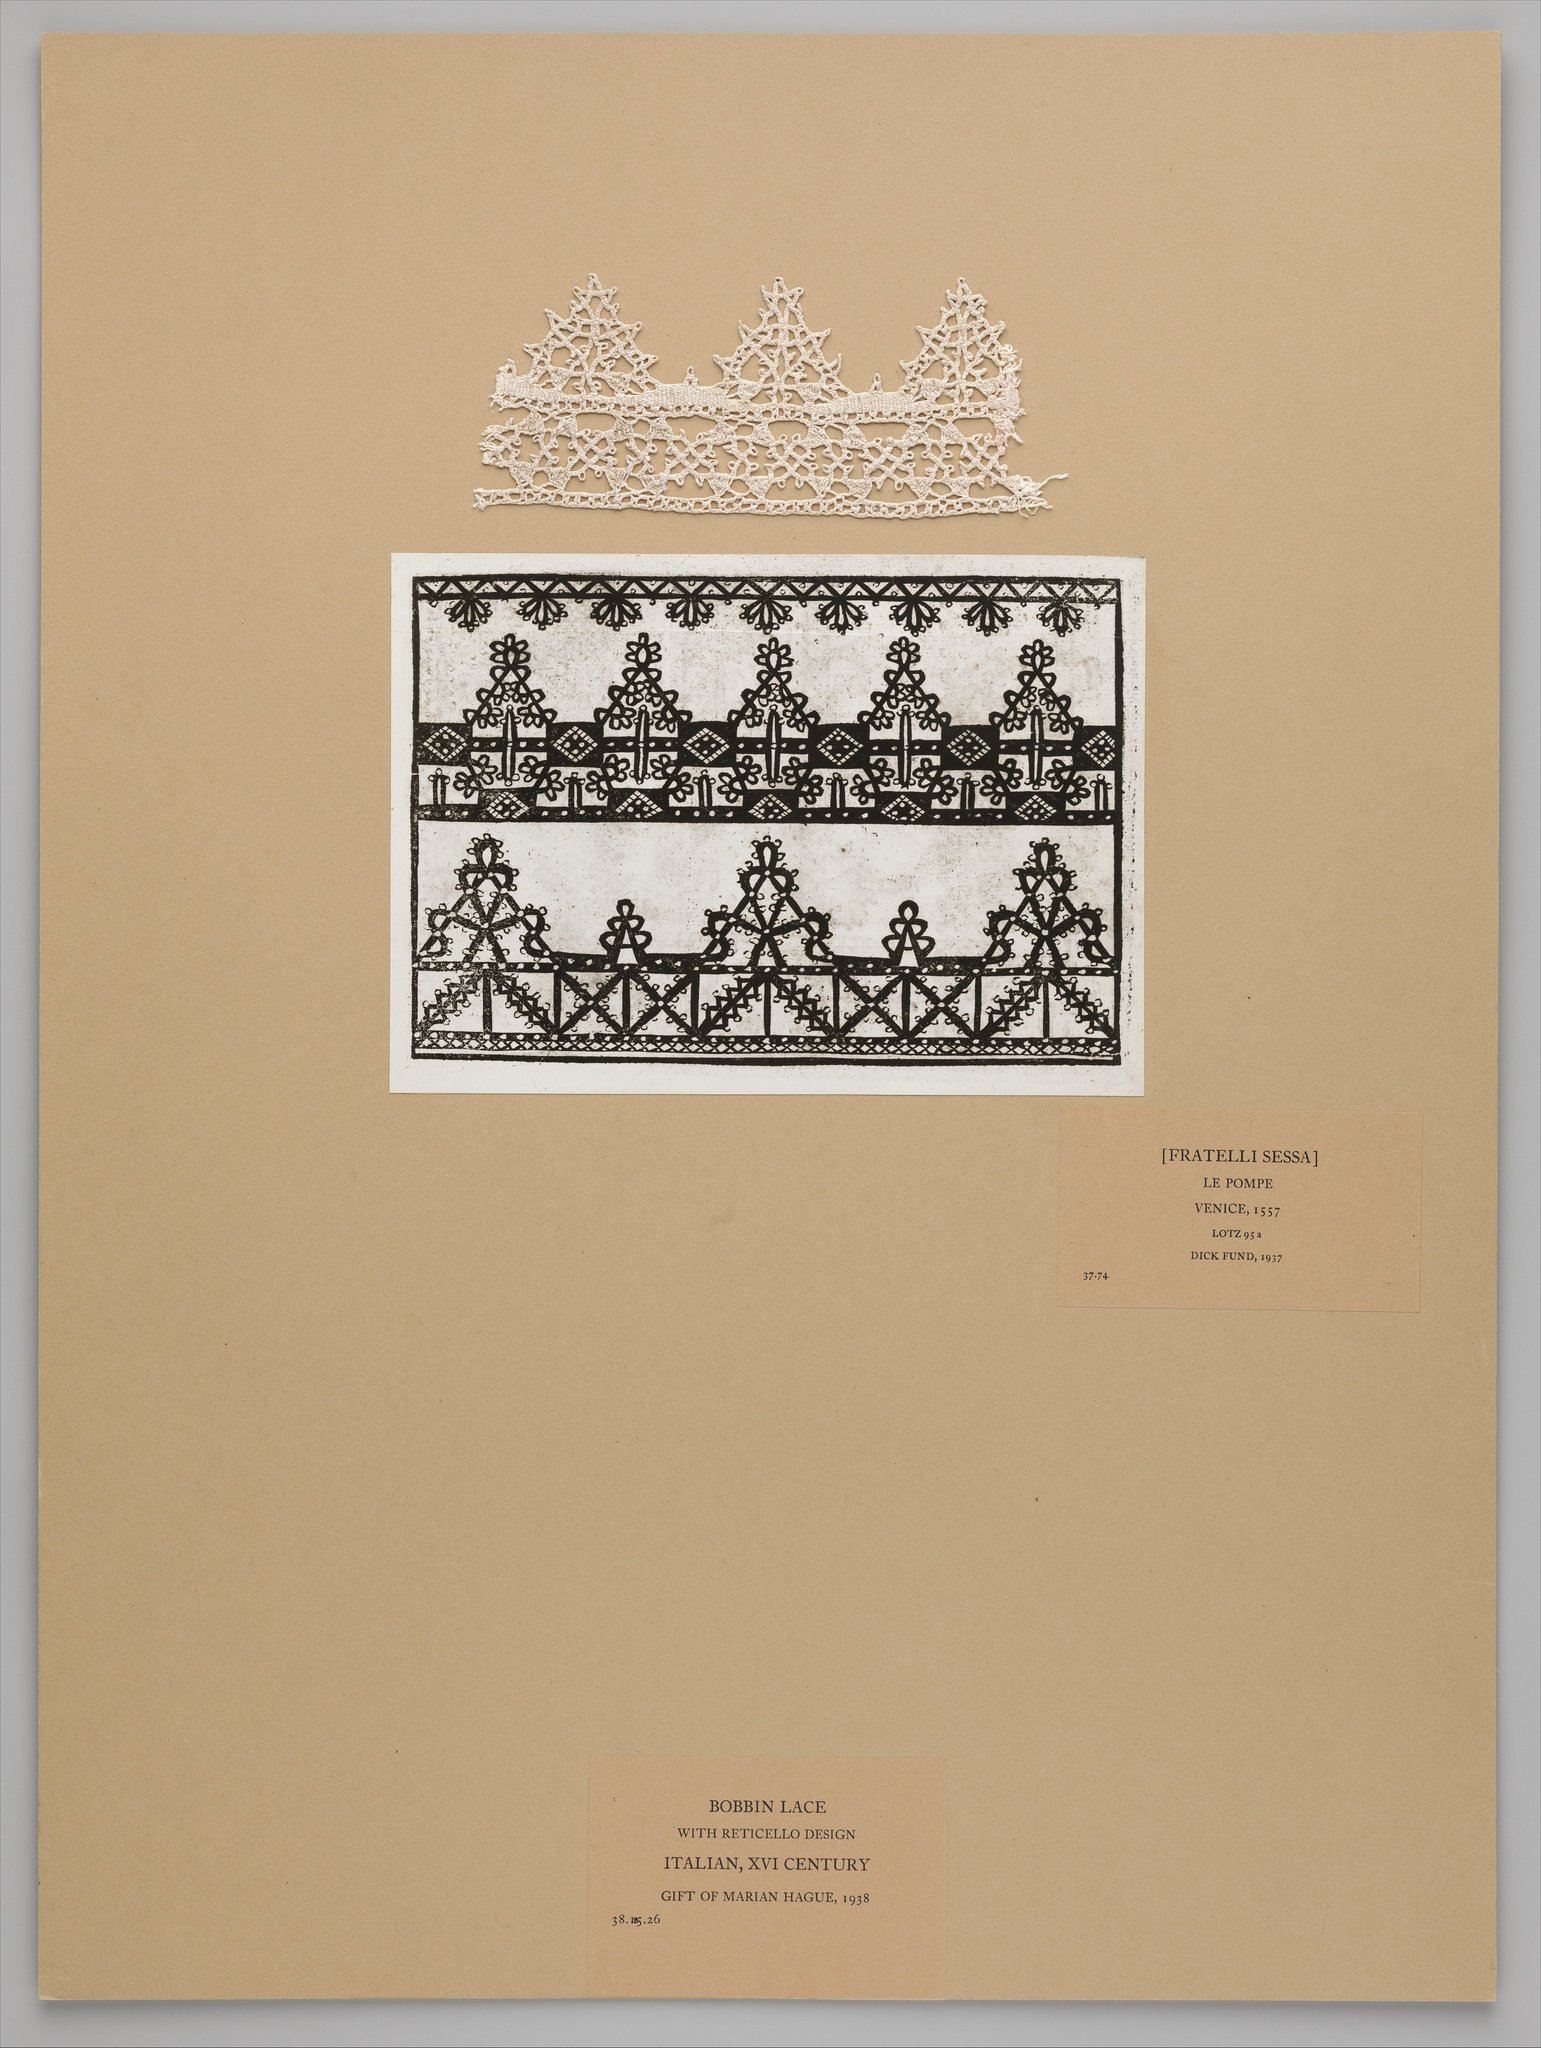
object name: insertion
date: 1501-1600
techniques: lace